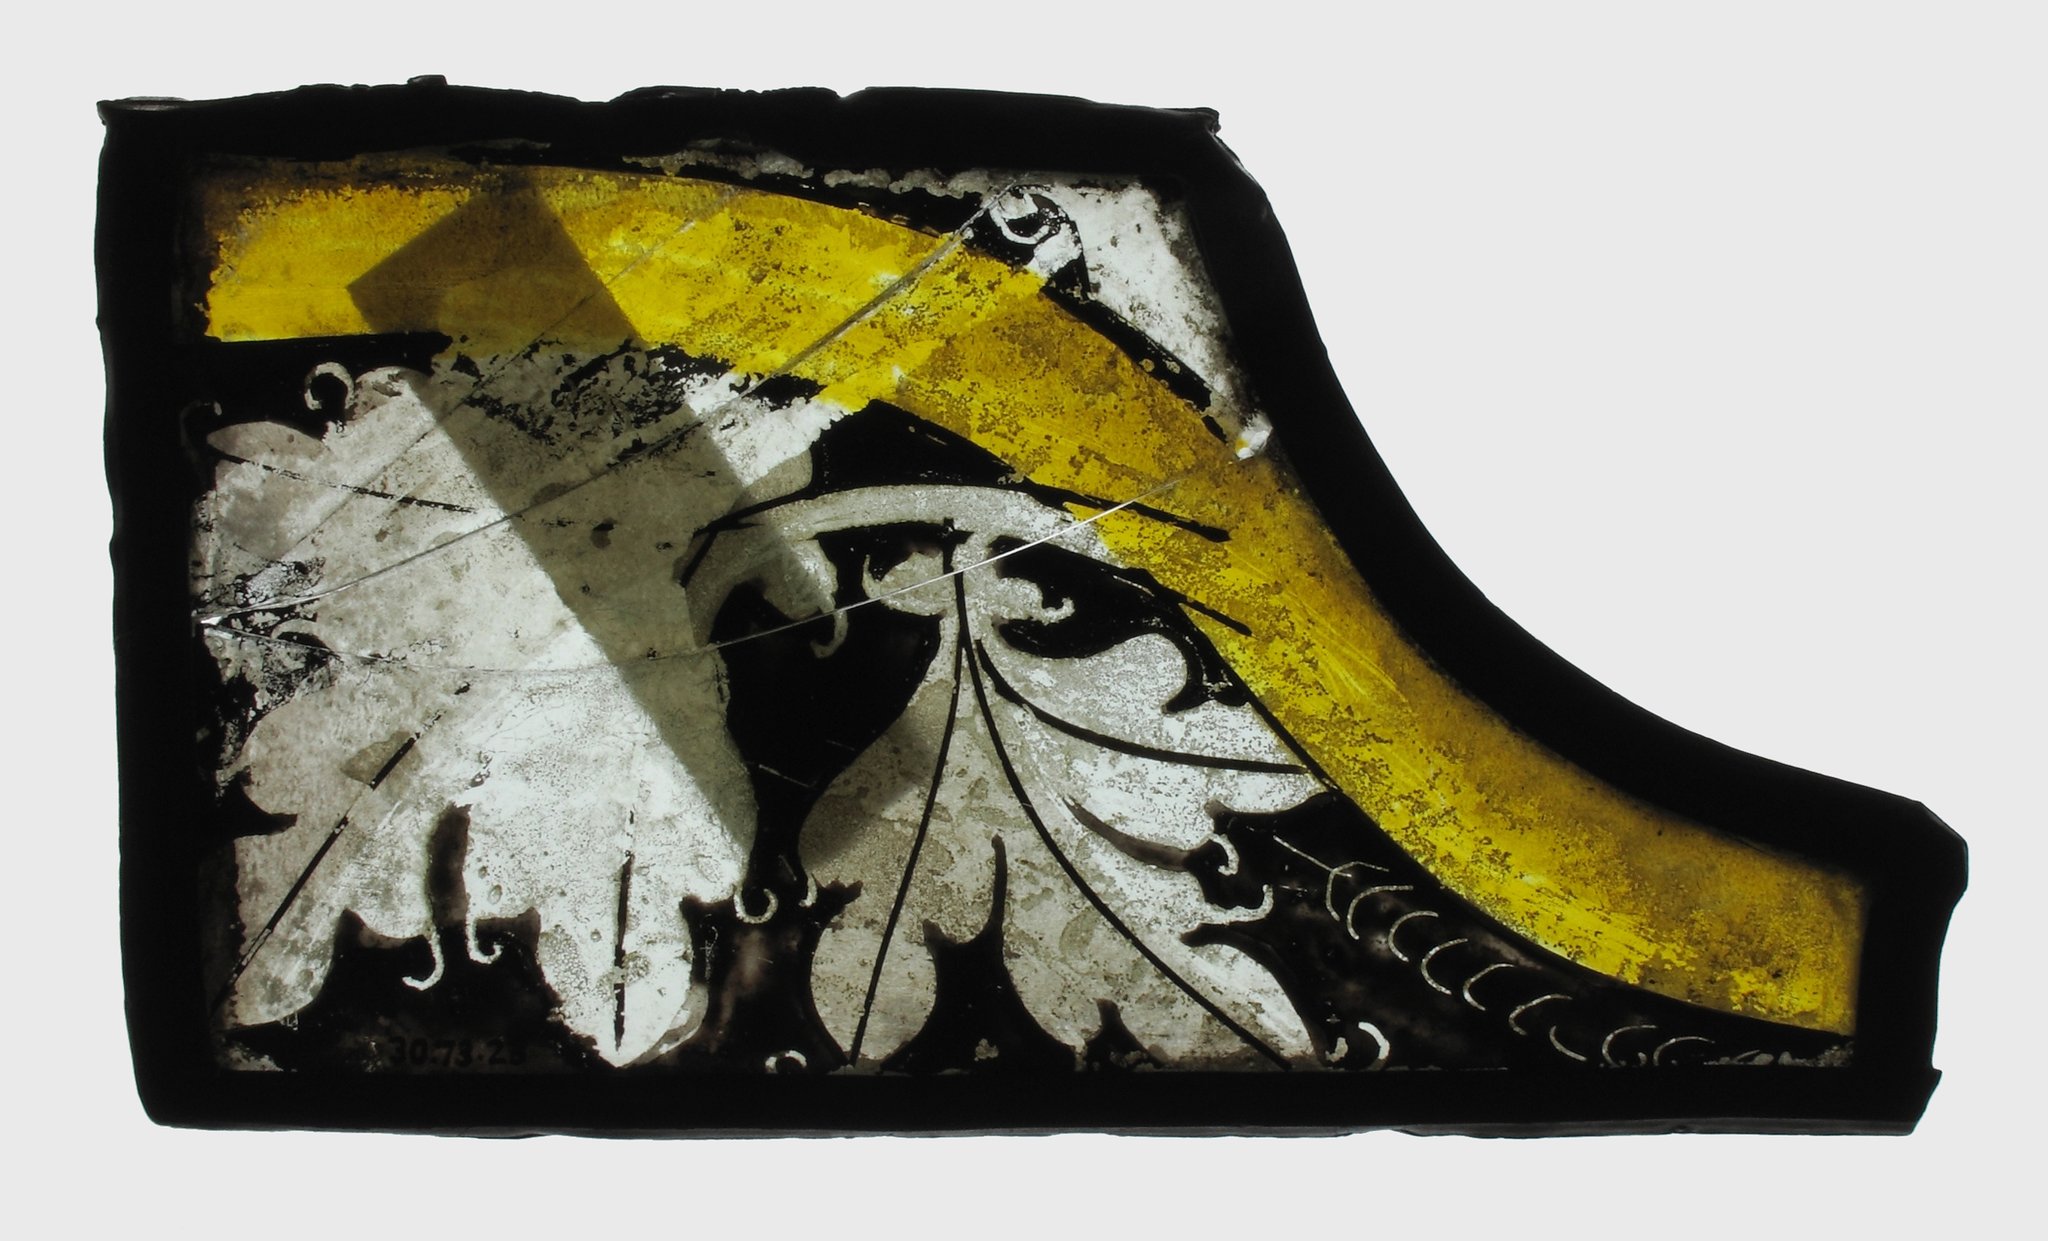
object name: fragment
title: Glass Fragment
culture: european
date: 1401-1500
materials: glass